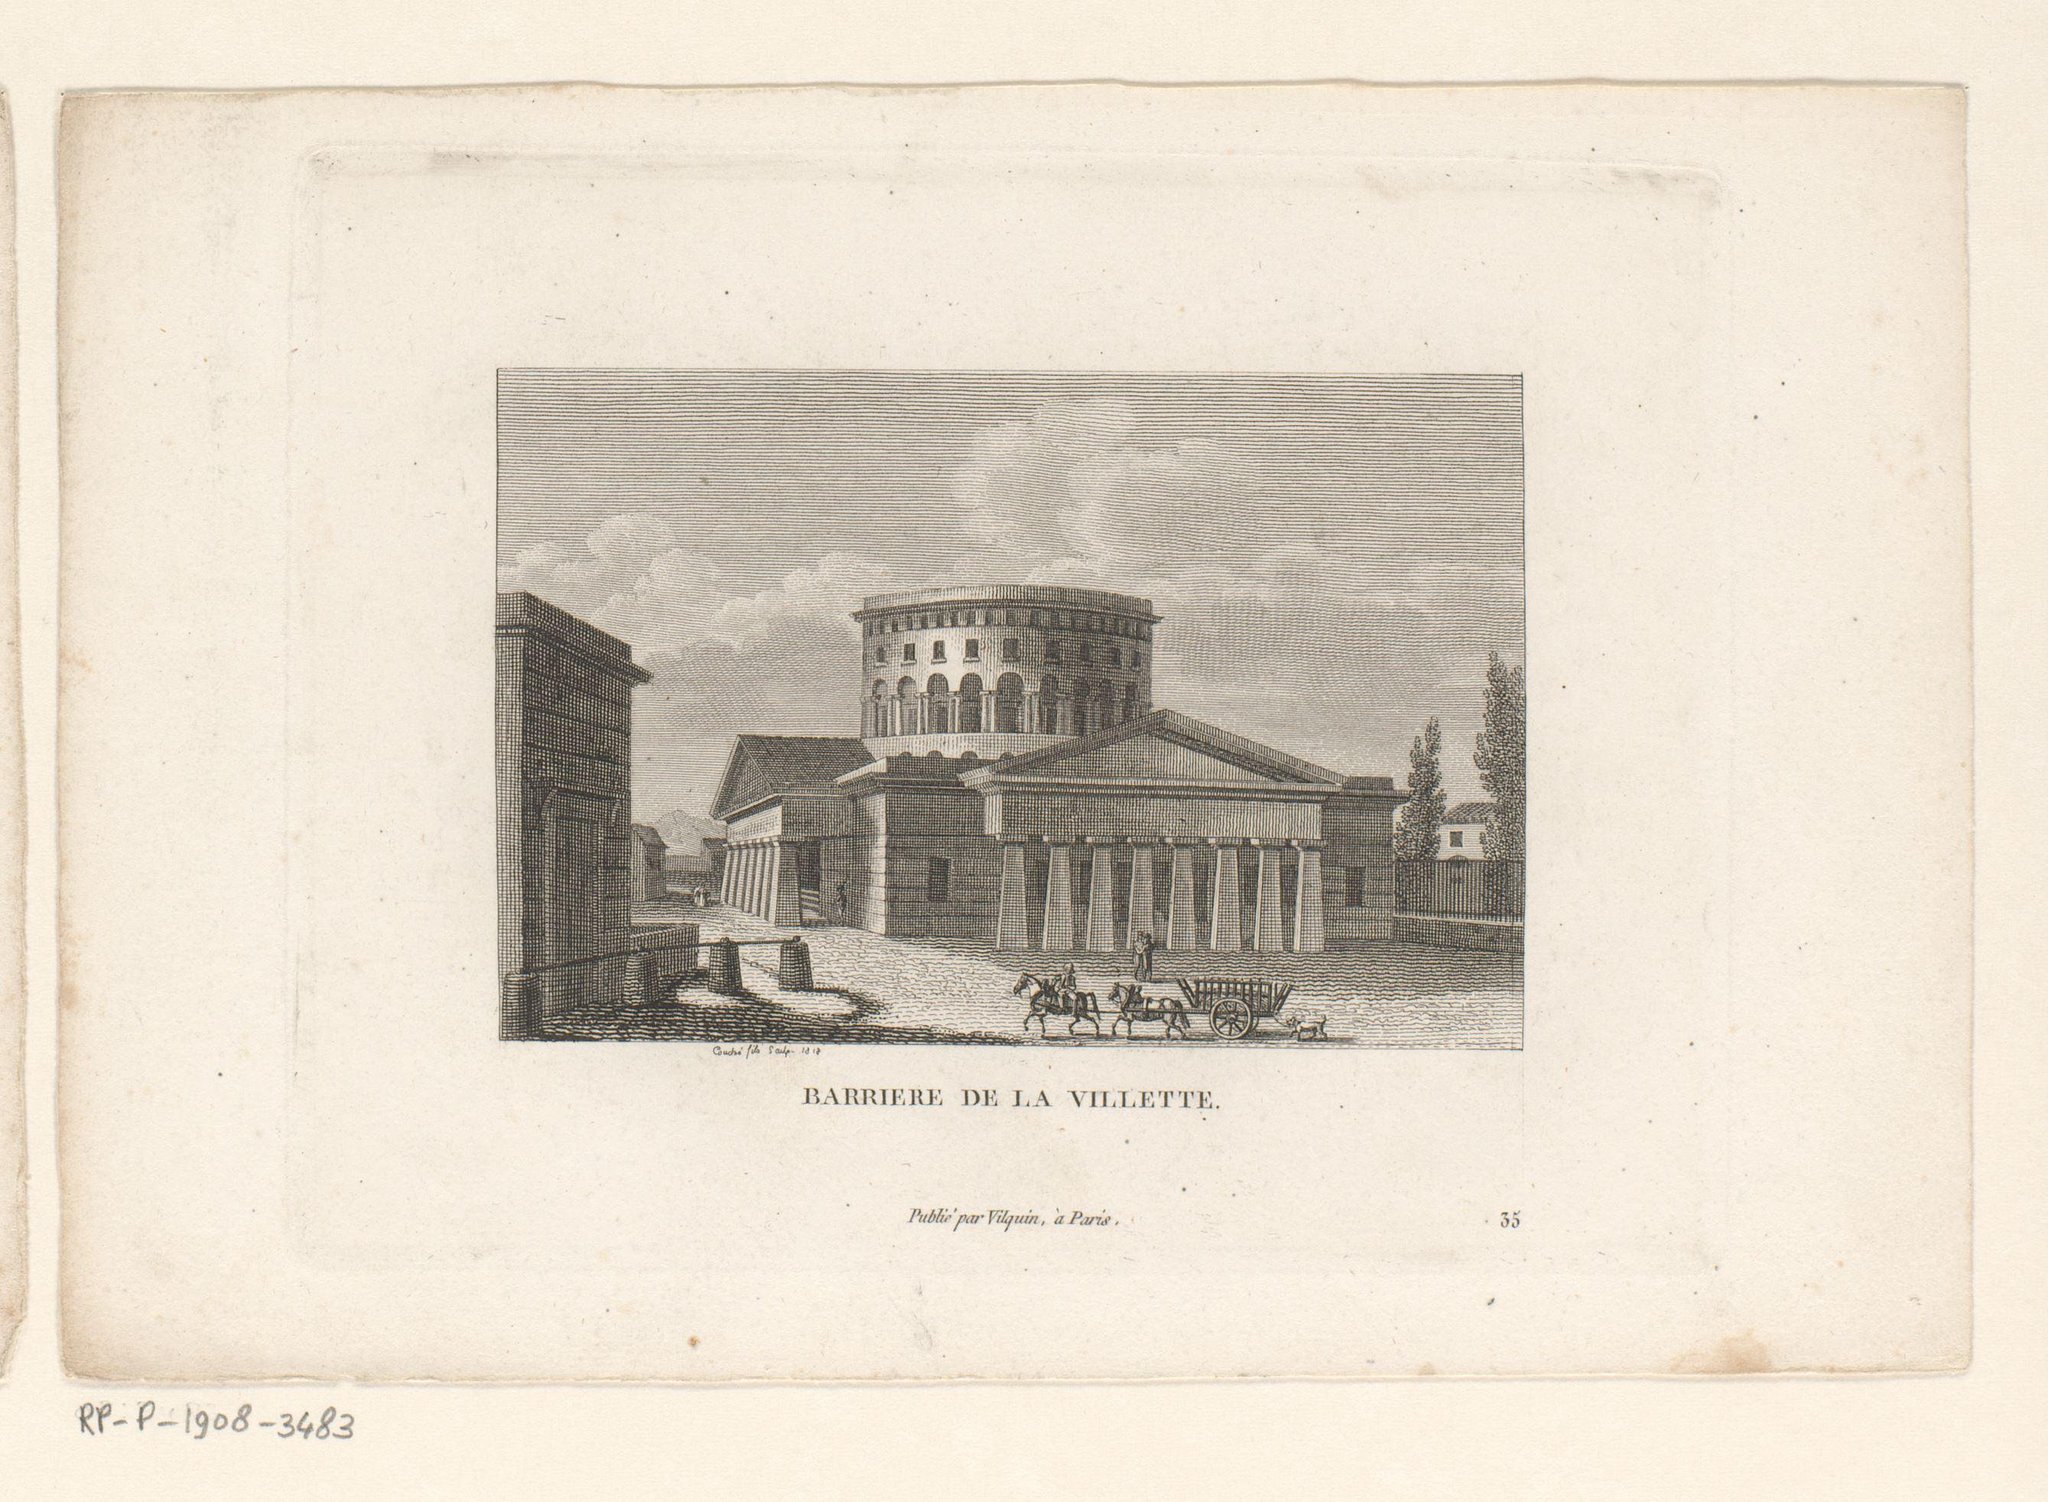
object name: print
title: Gezichten op Parijs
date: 1818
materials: paper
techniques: etching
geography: paris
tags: city-view in general; 'veduta', paris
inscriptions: collector's mark: Lugt 2228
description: Maakt deel uit van een serie met 60 platen van monumenten, kathedralen en paleizen in Parijs.